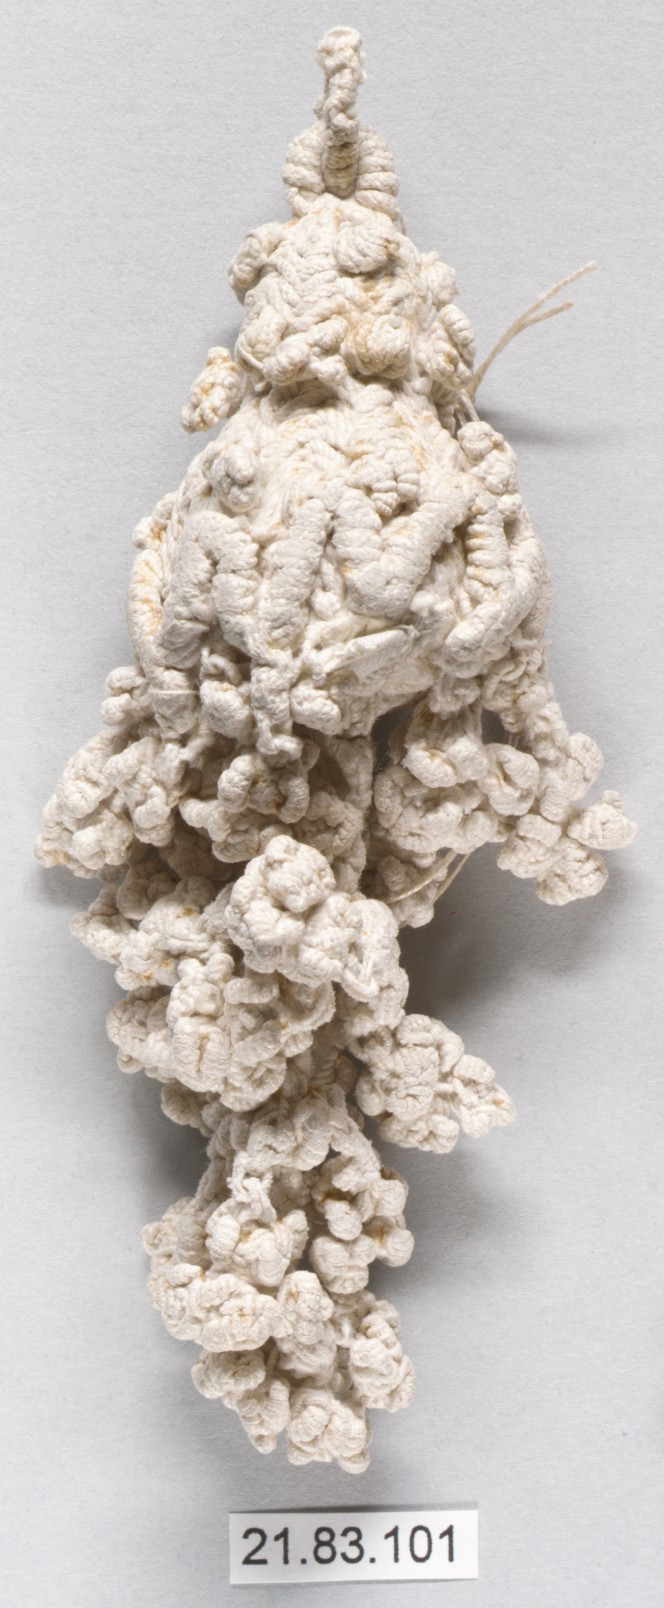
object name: tassel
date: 1601-1700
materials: linen